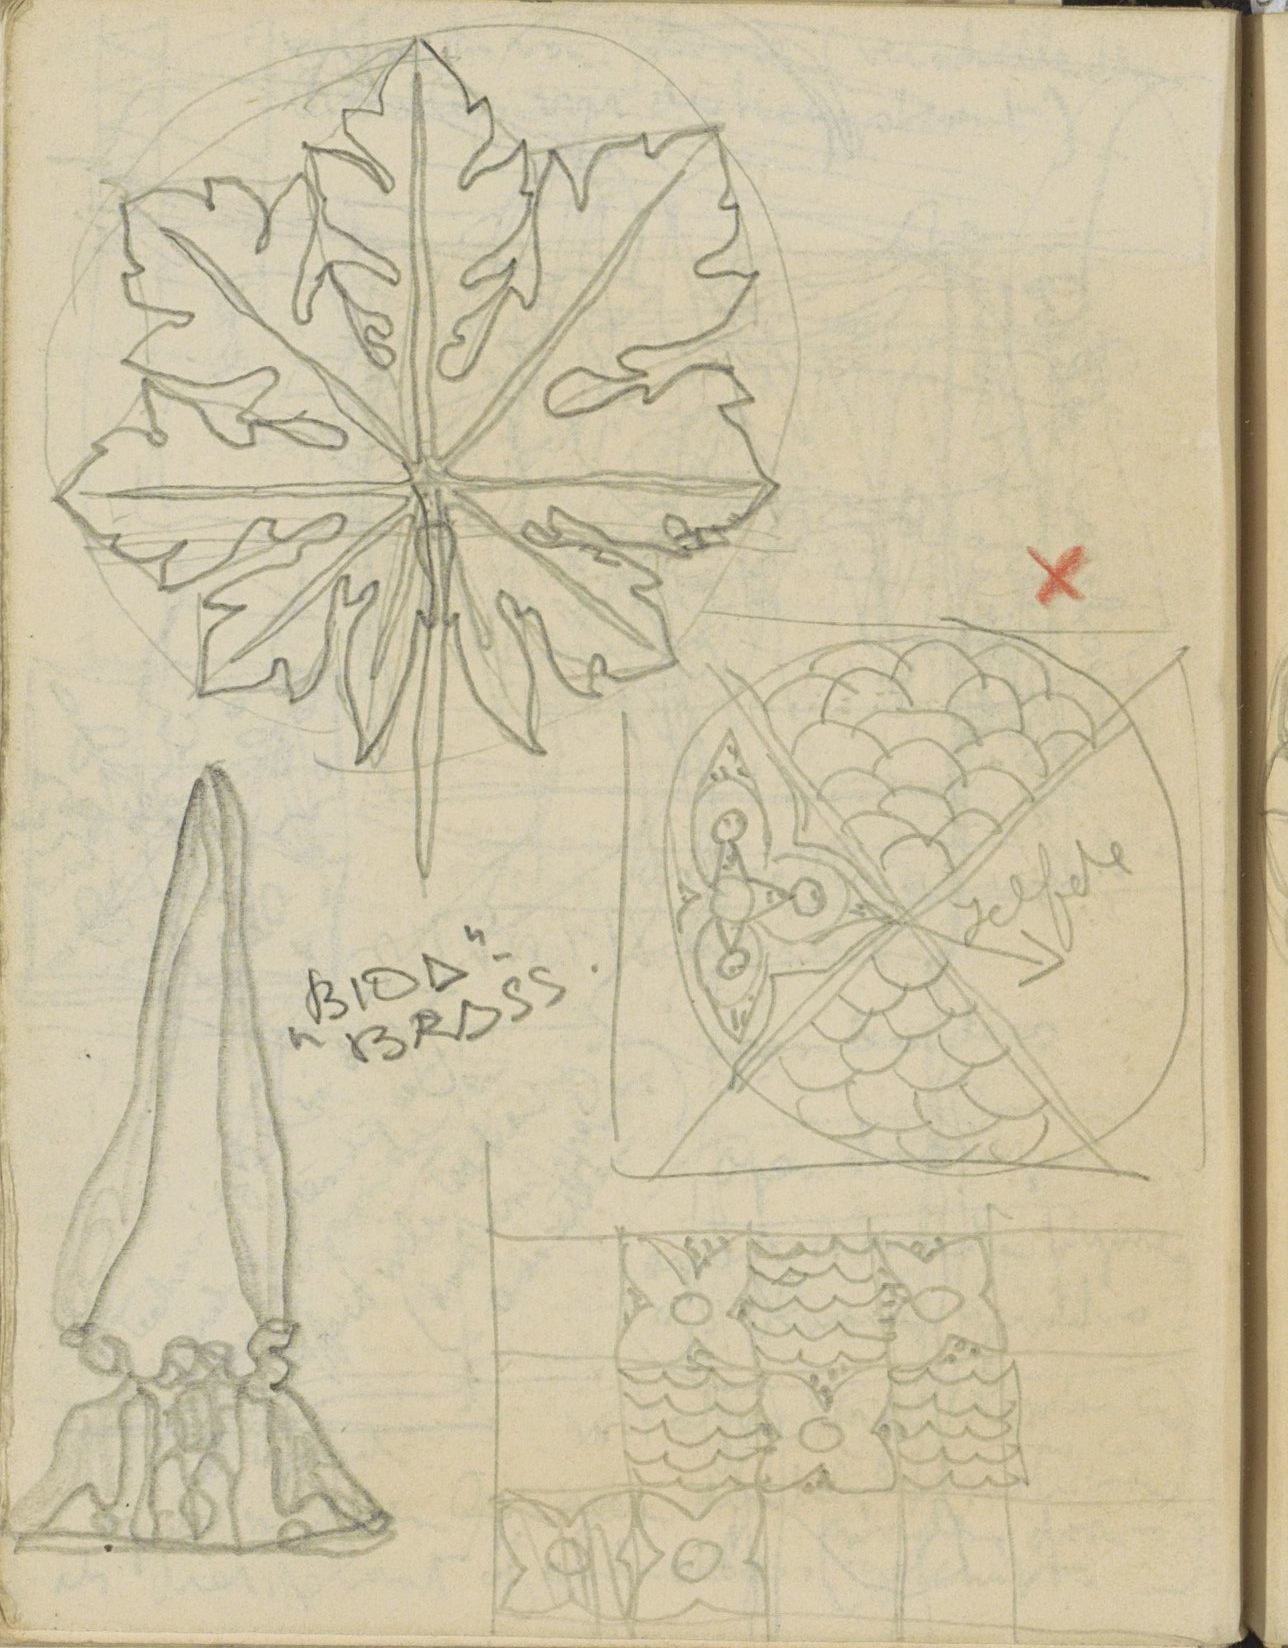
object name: sketchbook leaf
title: Ornamenten met blad- en bloemmotieven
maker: reijer stolk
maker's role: draughtsman, print maker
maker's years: 1896-1945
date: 1916-1945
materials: paper, pencil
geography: africa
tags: ornament derived from plant forms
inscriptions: annotation: ‘BIO[...]/ BRASS’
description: Blad 57 verso uit een schetsboek met 60 bladen.